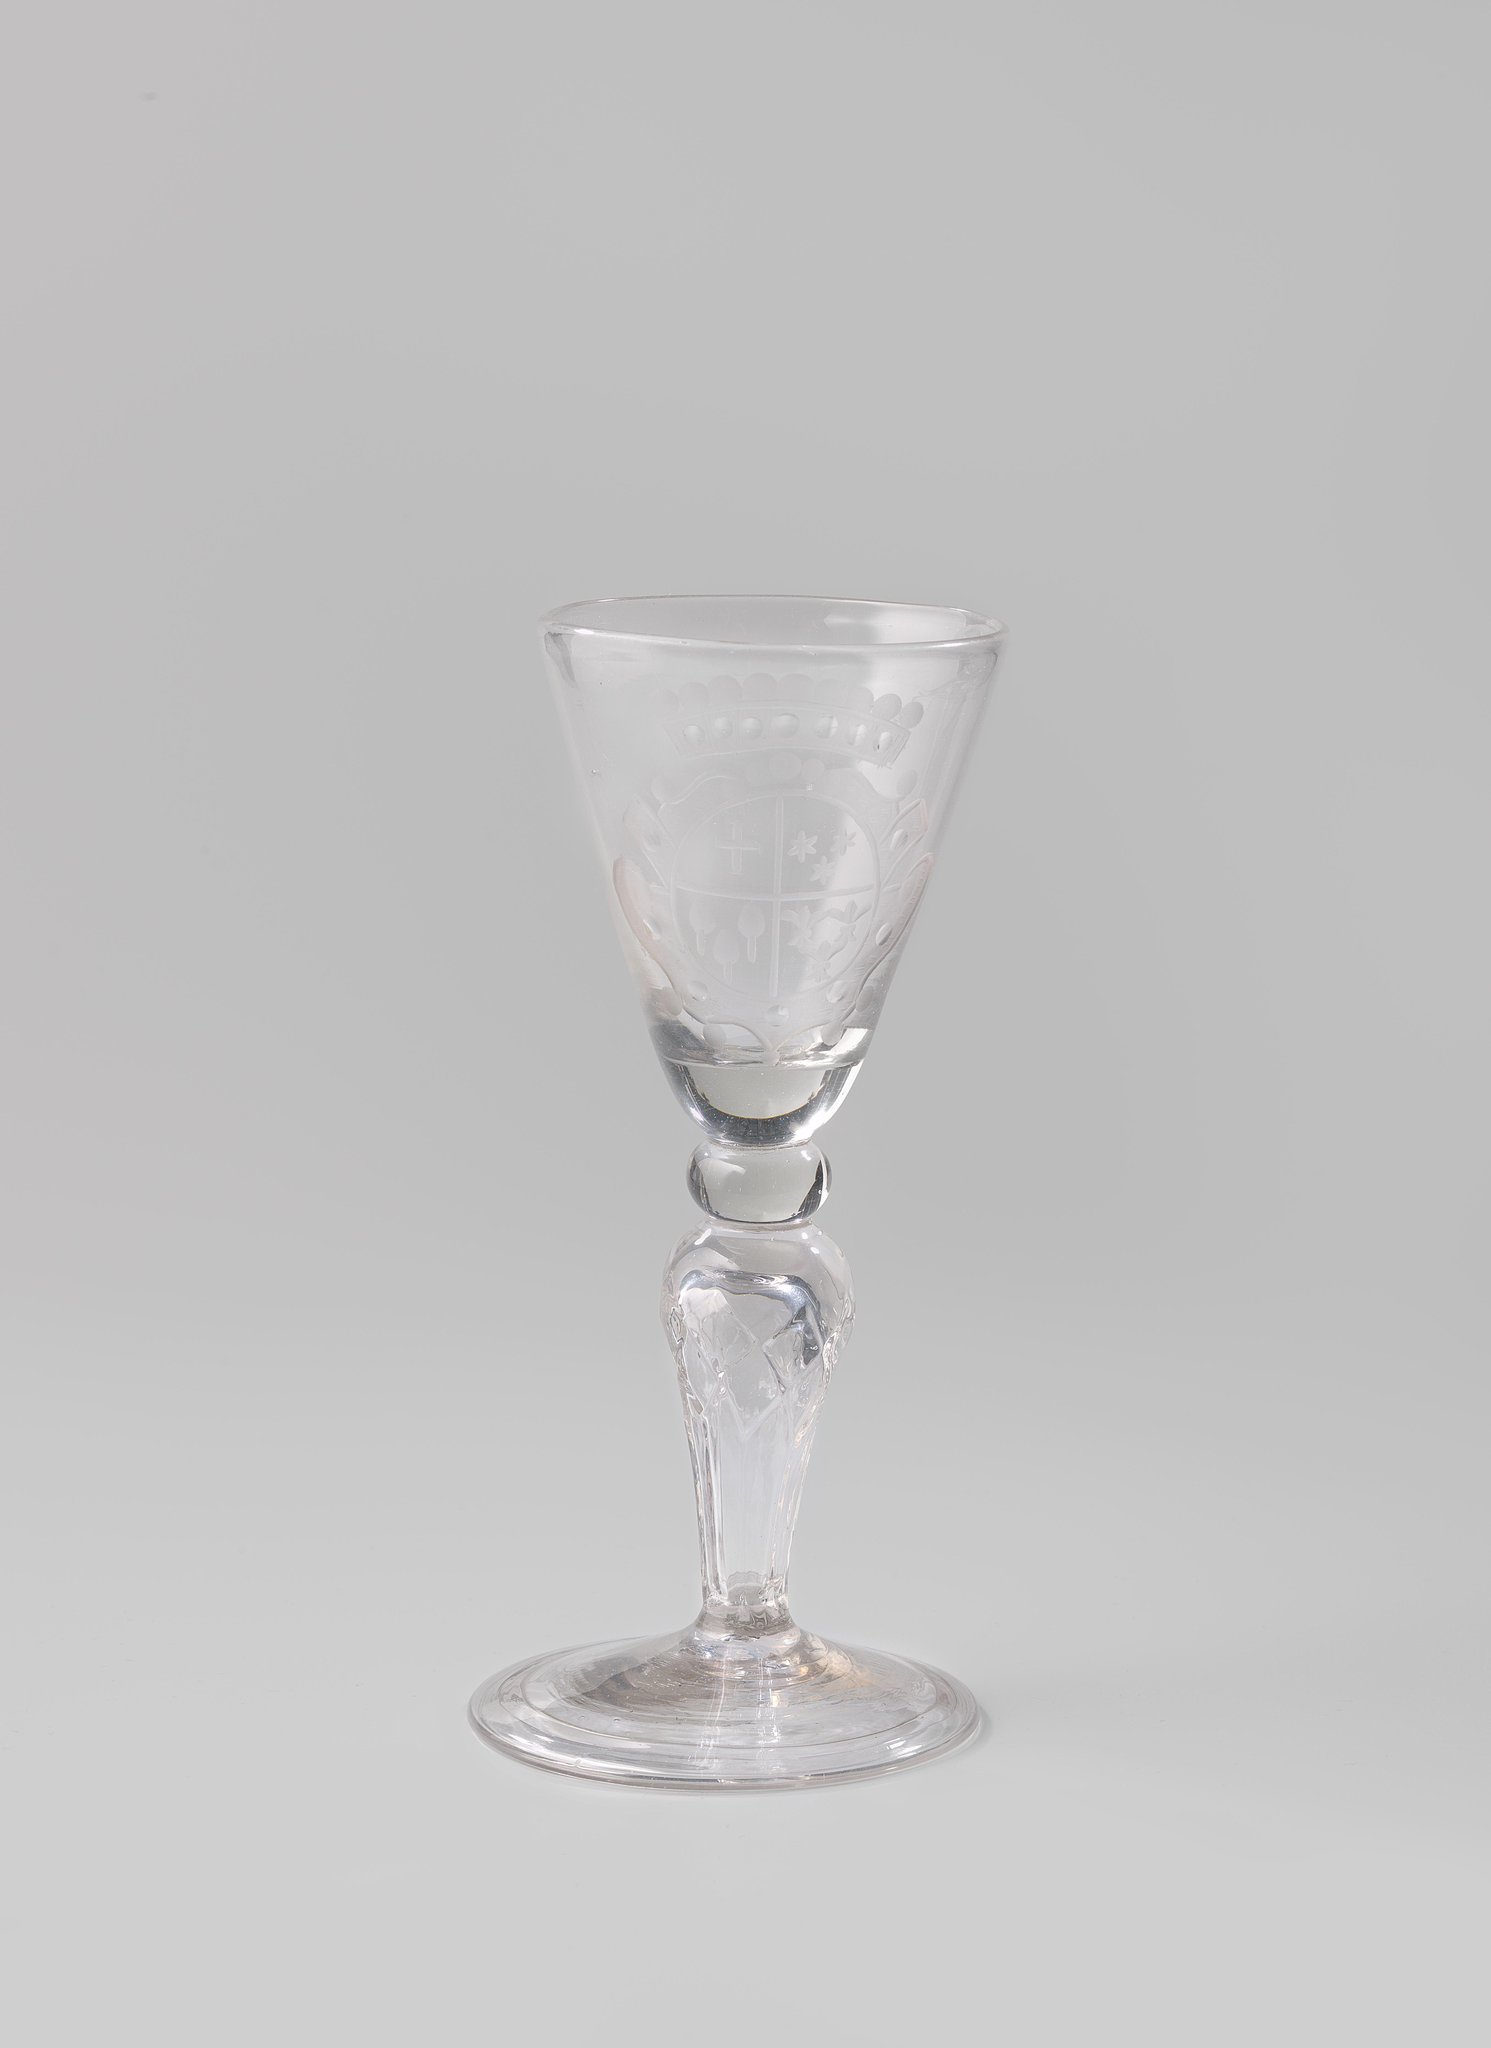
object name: goblet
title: Kelkglas met gekroond wapen van de familie Verstege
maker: Anonymous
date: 1725-1750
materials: glass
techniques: glassblowing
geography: northern netherlands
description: Konische voet. Zeshoekige in vorm geblazen stam met een knop en met diamantpatroon op de schouder. Trechtervormige kelk met afgeronde onderzijde. Op de kelk, in een rond schild omgeven door een cartouche, het gekroonde wapen van de Zutphense familie Verstege.